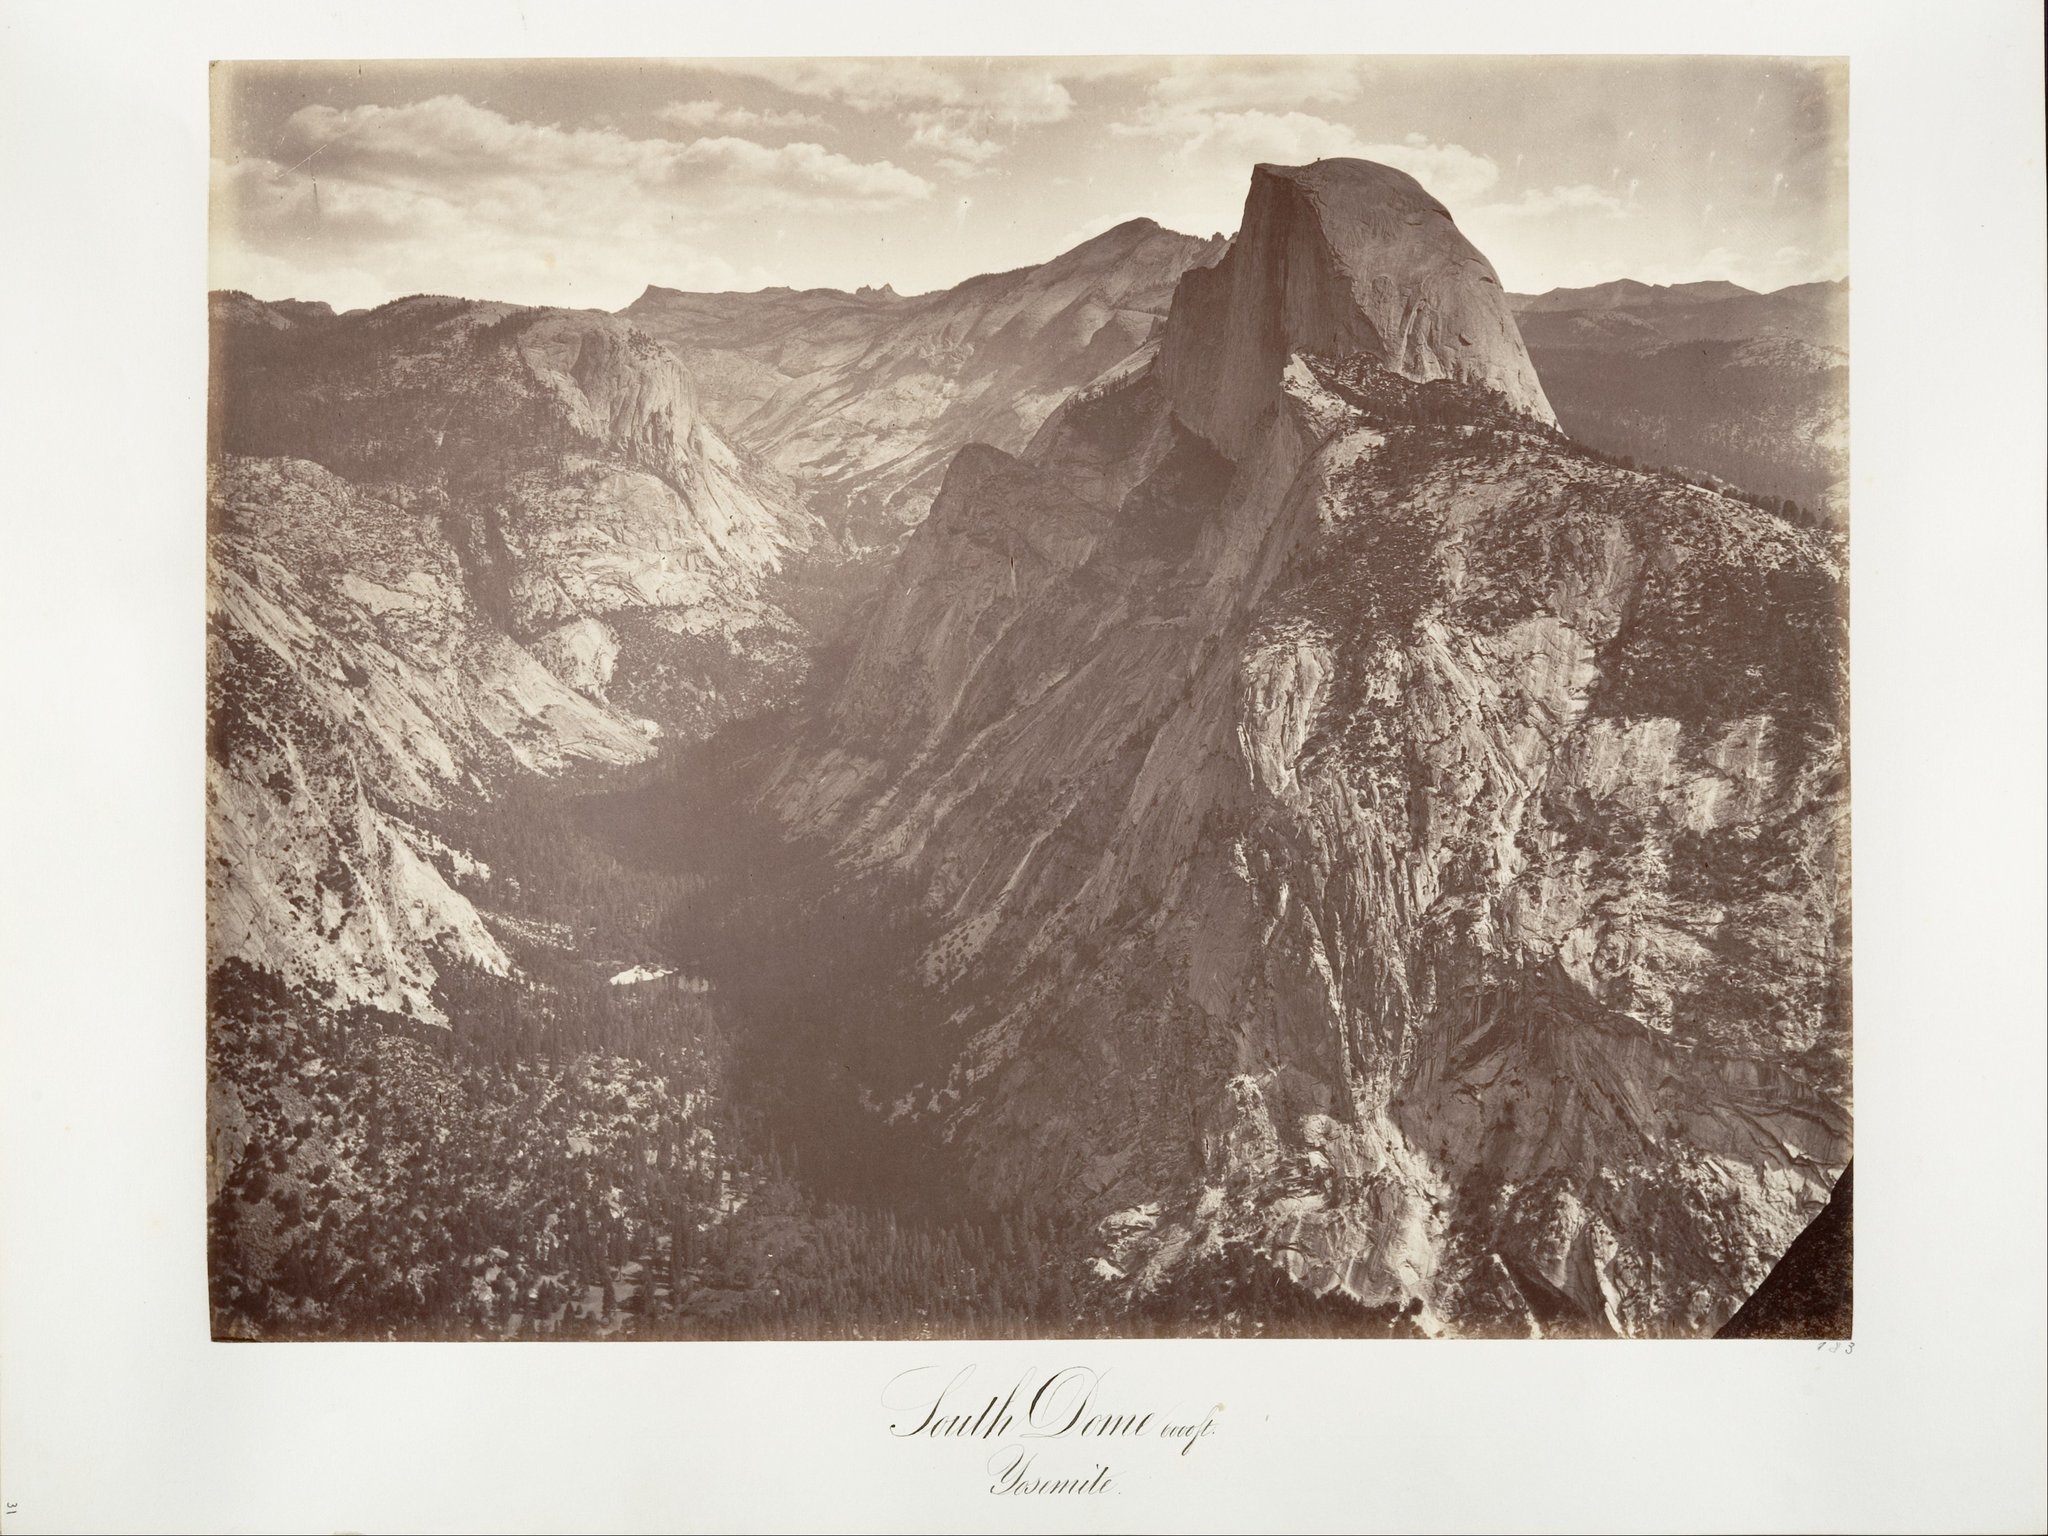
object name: photograph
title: South Dome, 6,000 feet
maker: carleton e. watkins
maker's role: artist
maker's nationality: american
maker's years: 1829-1916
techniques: albumen silver print, glass negative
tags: mountains,landscapes